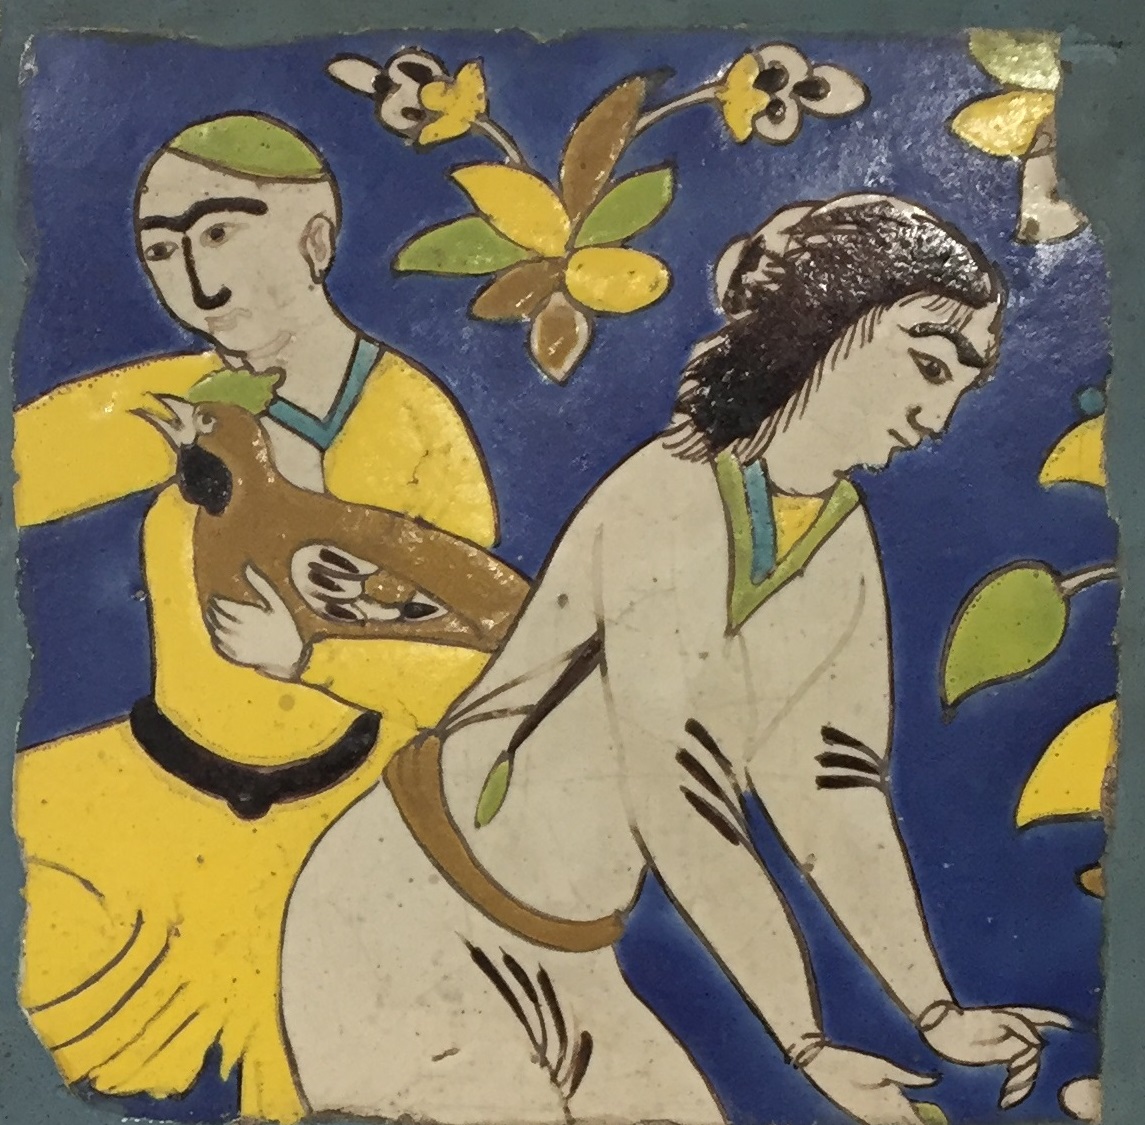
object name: tile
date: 1701-1800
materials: stonepaste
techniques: glazing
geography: iran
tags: birds,men,women